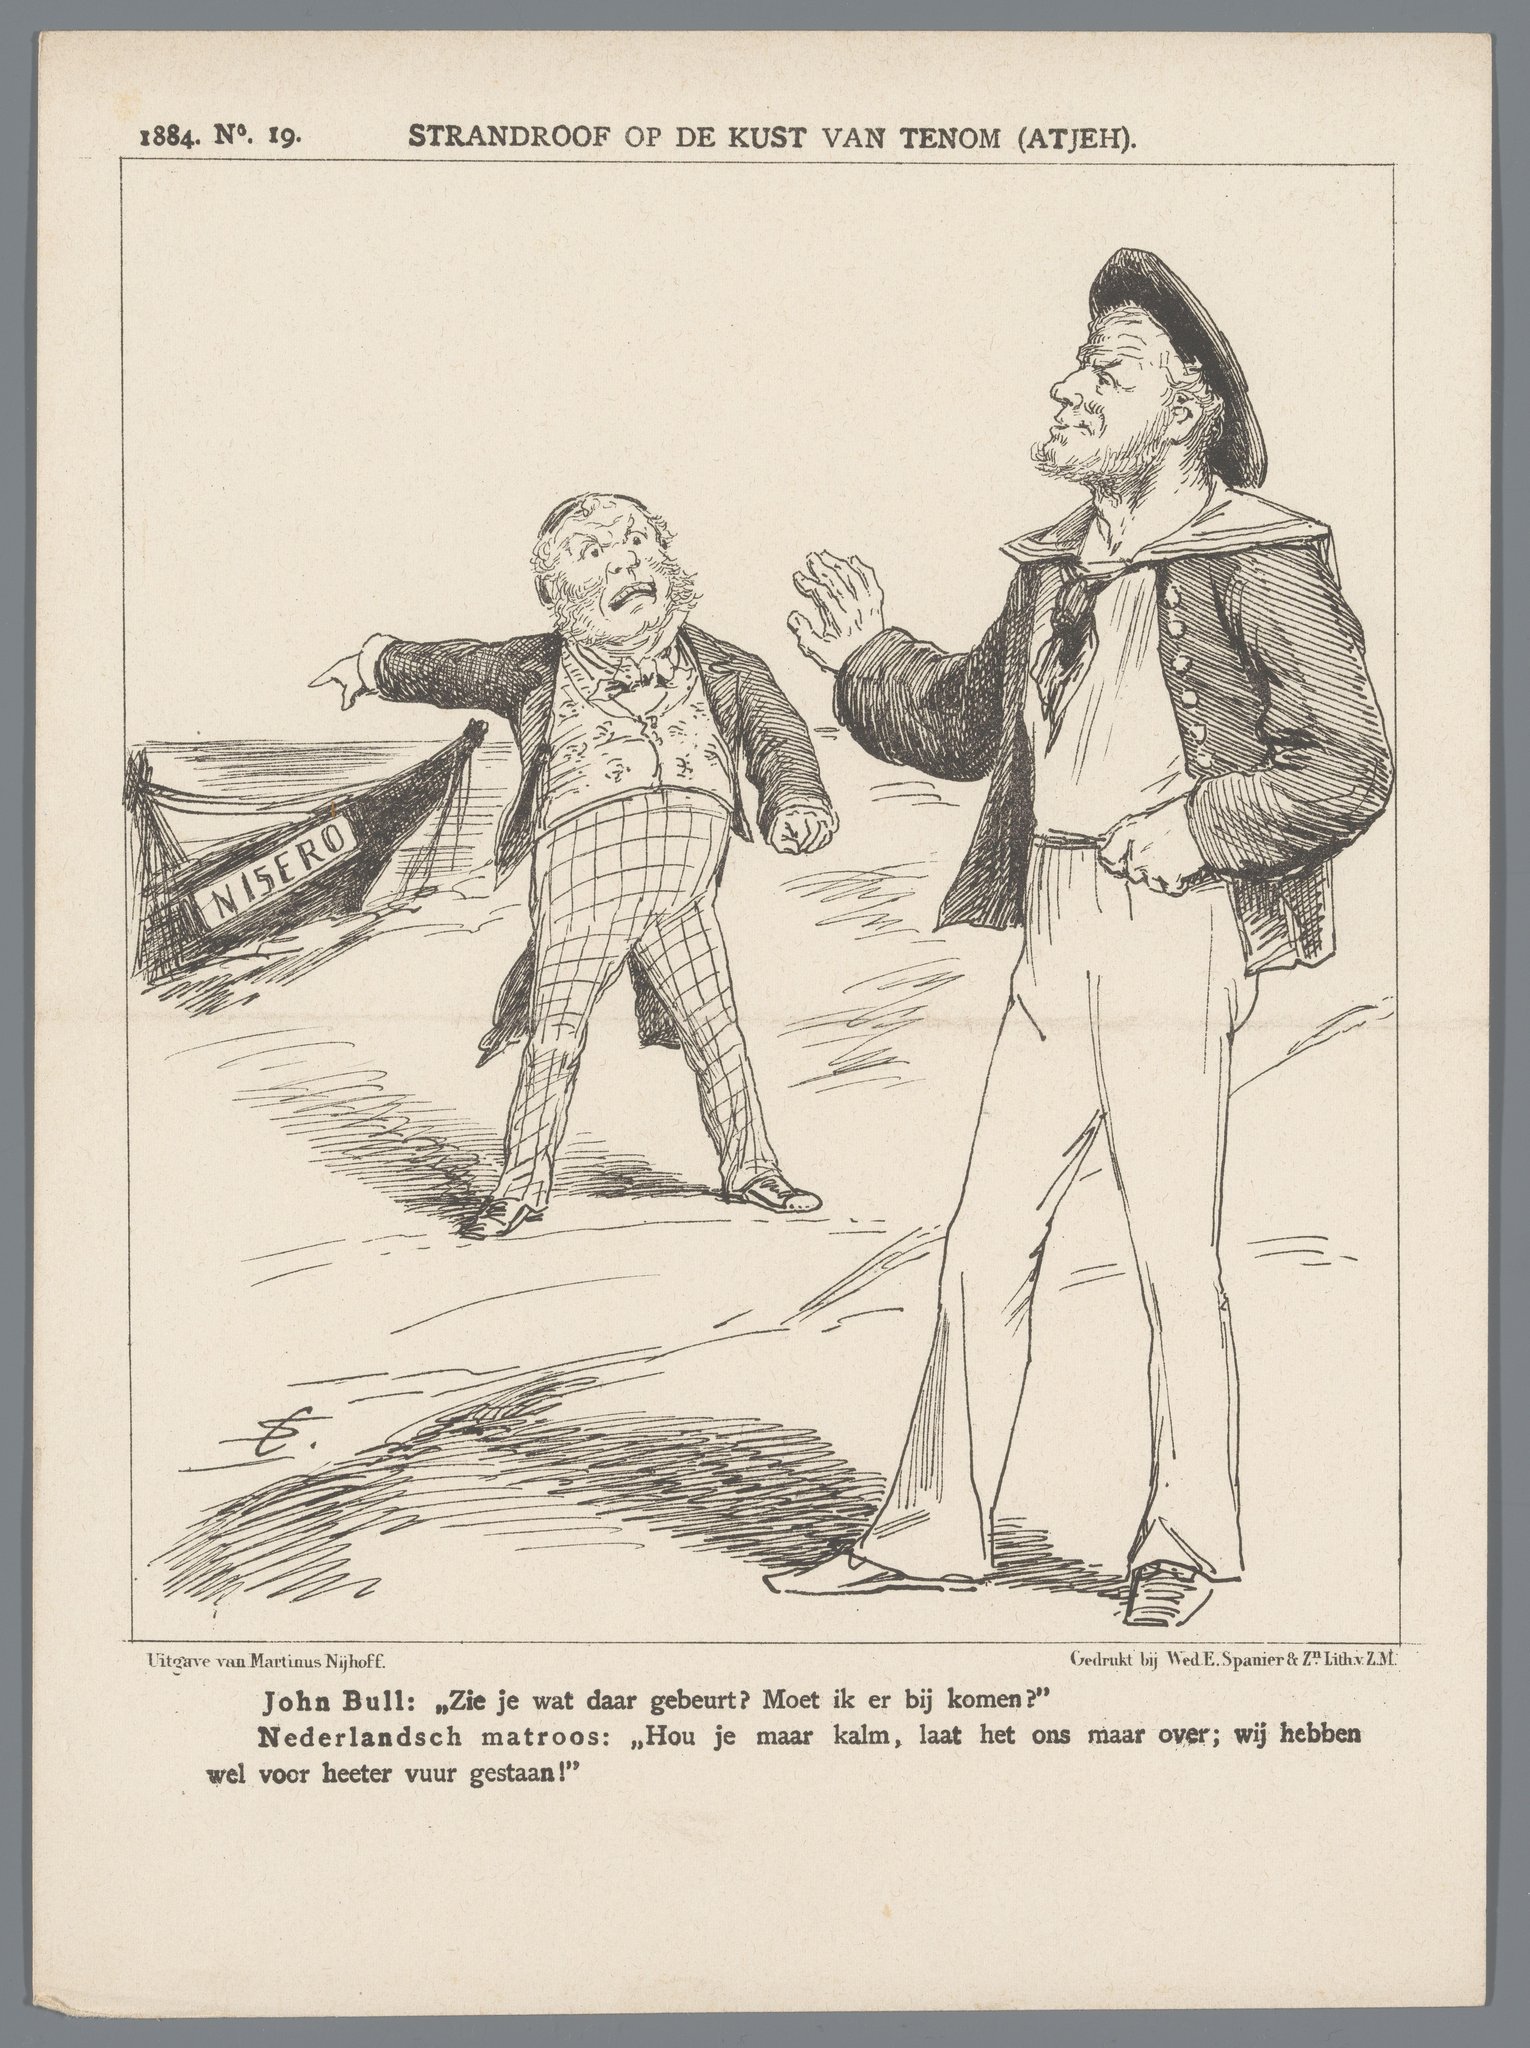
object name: cartoon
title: Strandroof op de kust van Tenom (Atjeh)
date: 1884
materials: paper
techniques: lithograph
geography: netherlands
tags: atjeh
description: Spotprent over het stranden van het Britse schip de Nisero op het strand van Tenom op Atjeh. Plaat verschenen bij het weekblad De Nederlandsche Spectator, nr. 19, 1884.